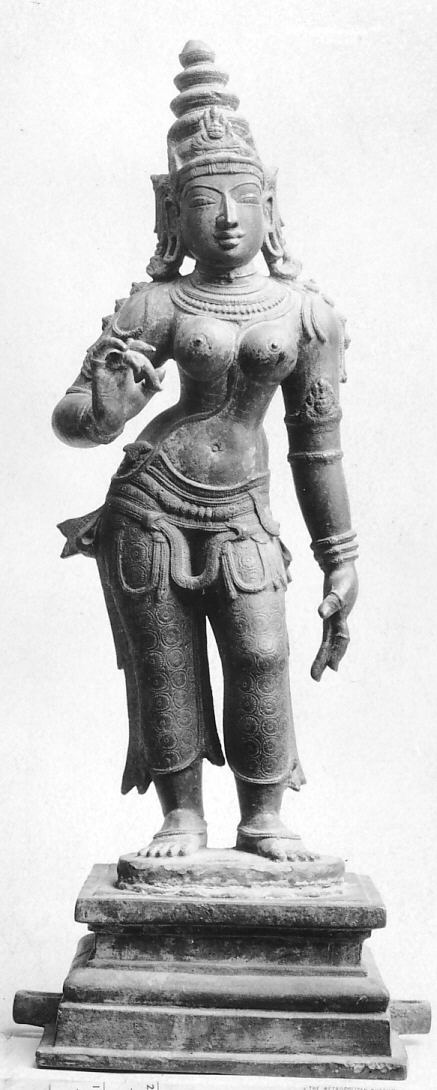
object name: figure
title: Parvati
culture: tamil nadu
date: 1501-1600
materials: bronze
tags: parvati,hinduism